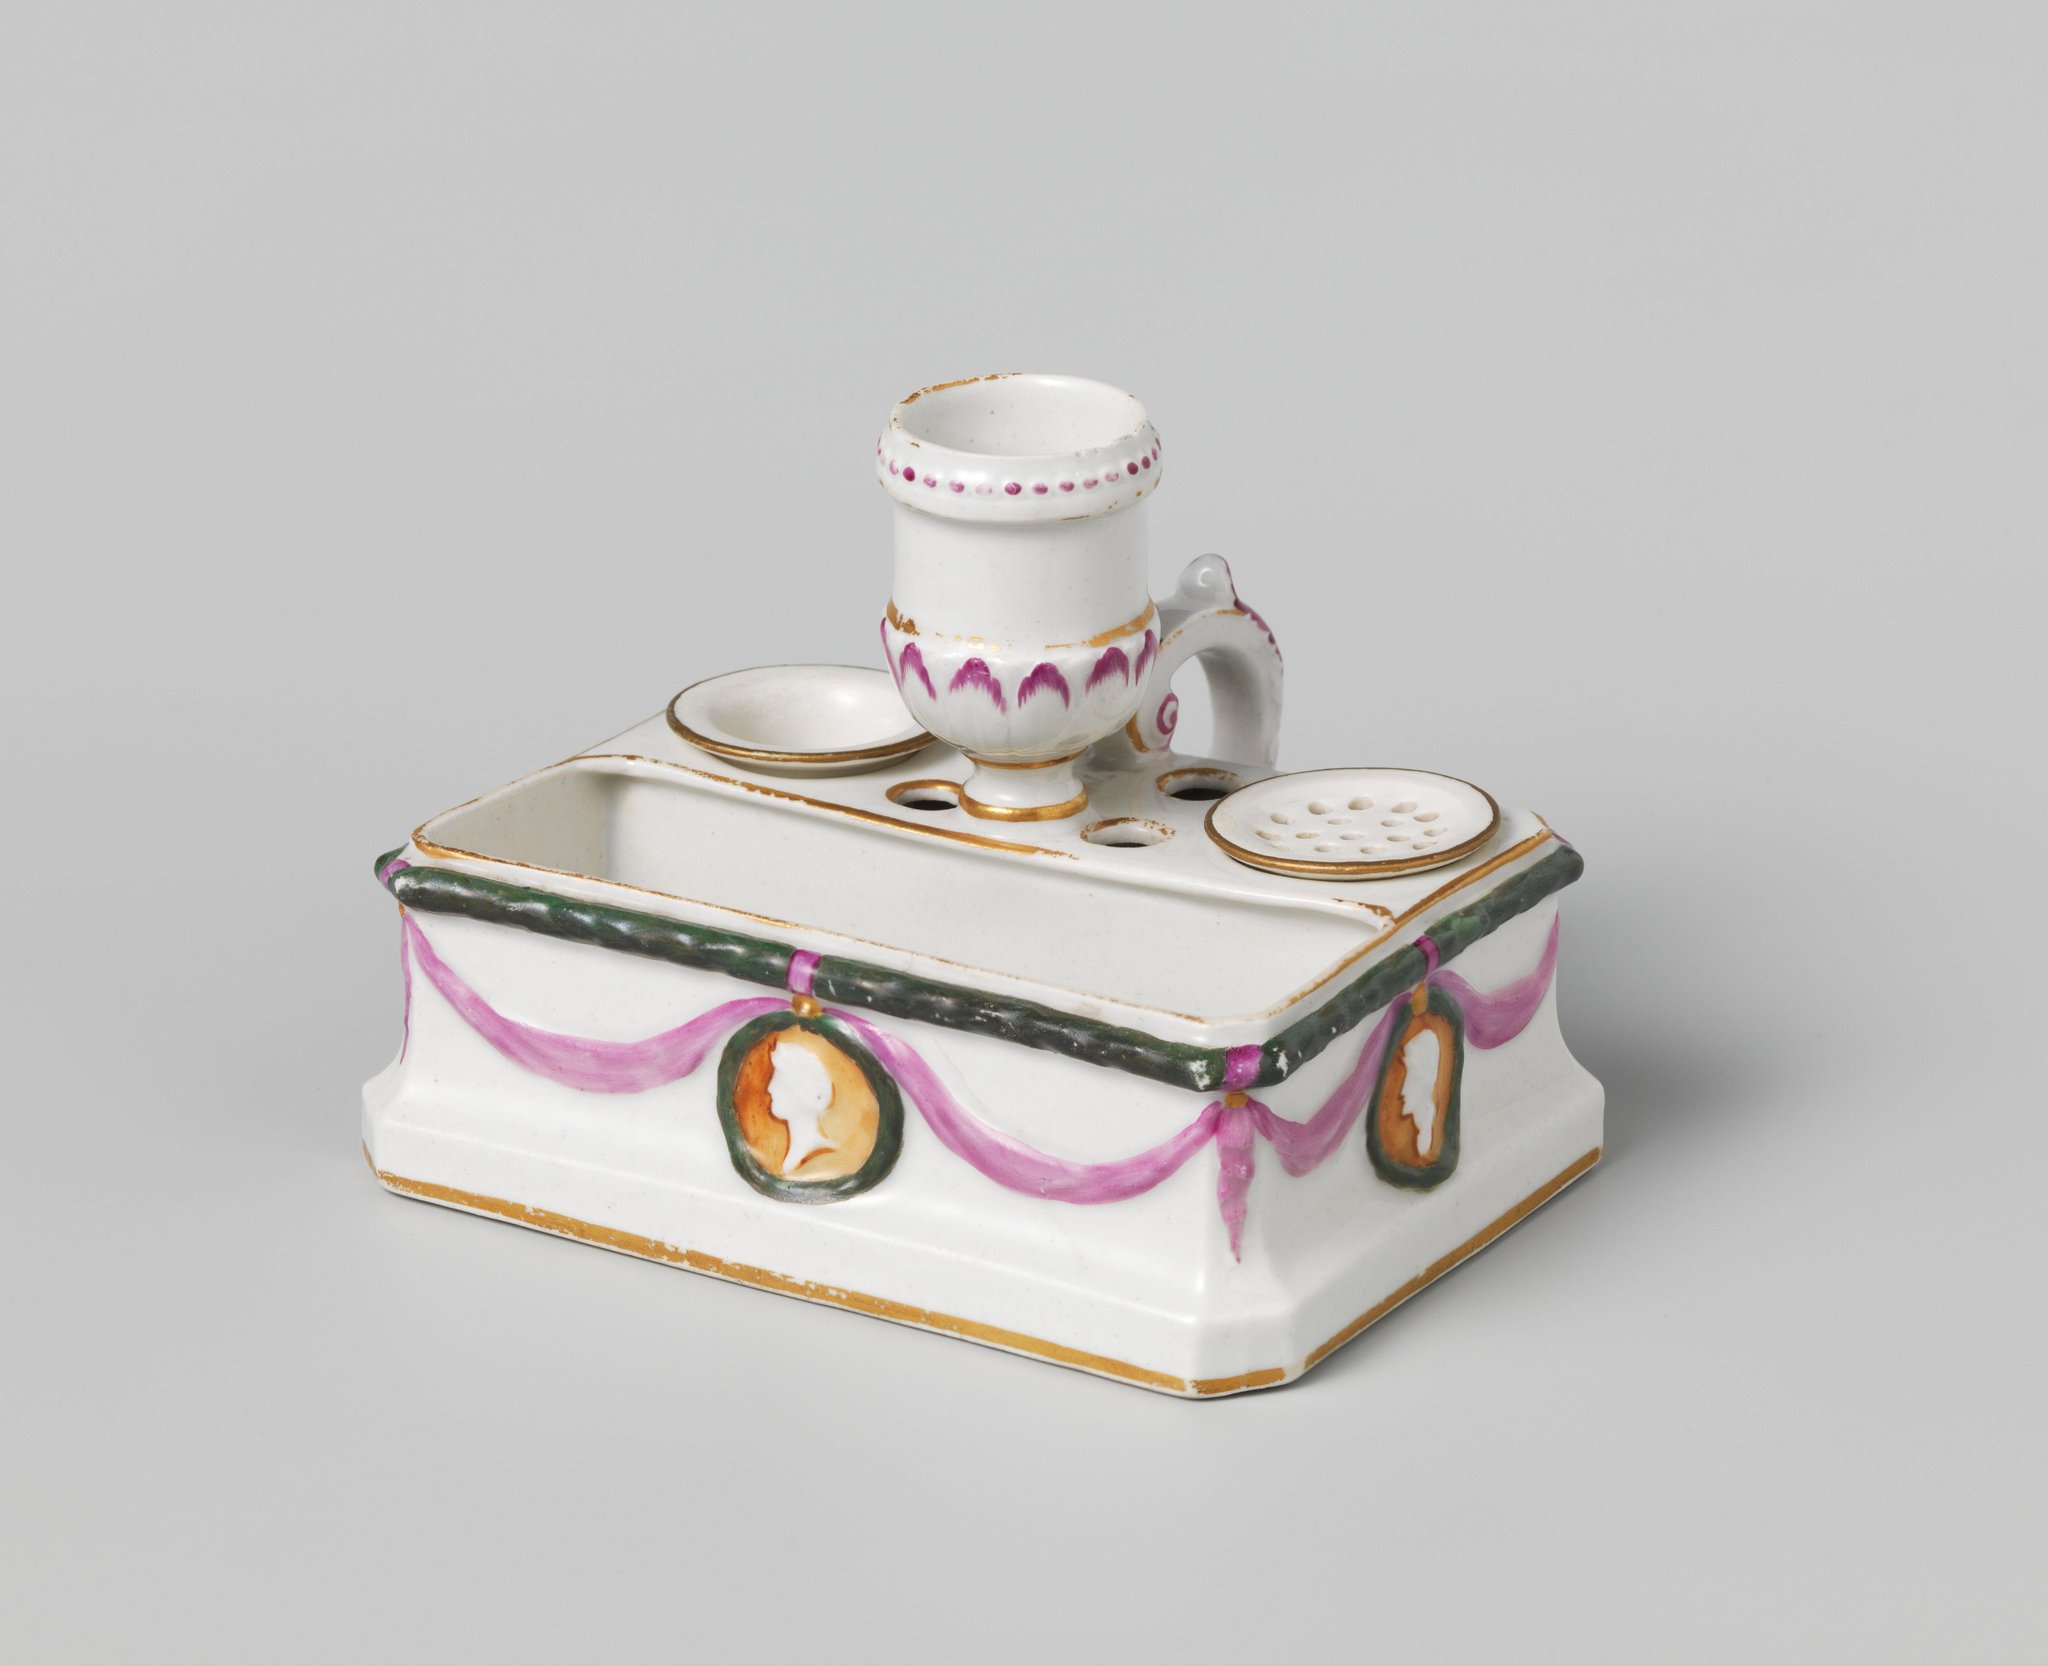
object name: inkwell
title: Inktpot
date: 1778-1782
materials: porcelain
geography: loosdrecht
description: In het gesloten achterste deel van het inktstel gaten voor een inktpotje en een zandstrooier (beide aanwezig) en vier gaten voor pennen.